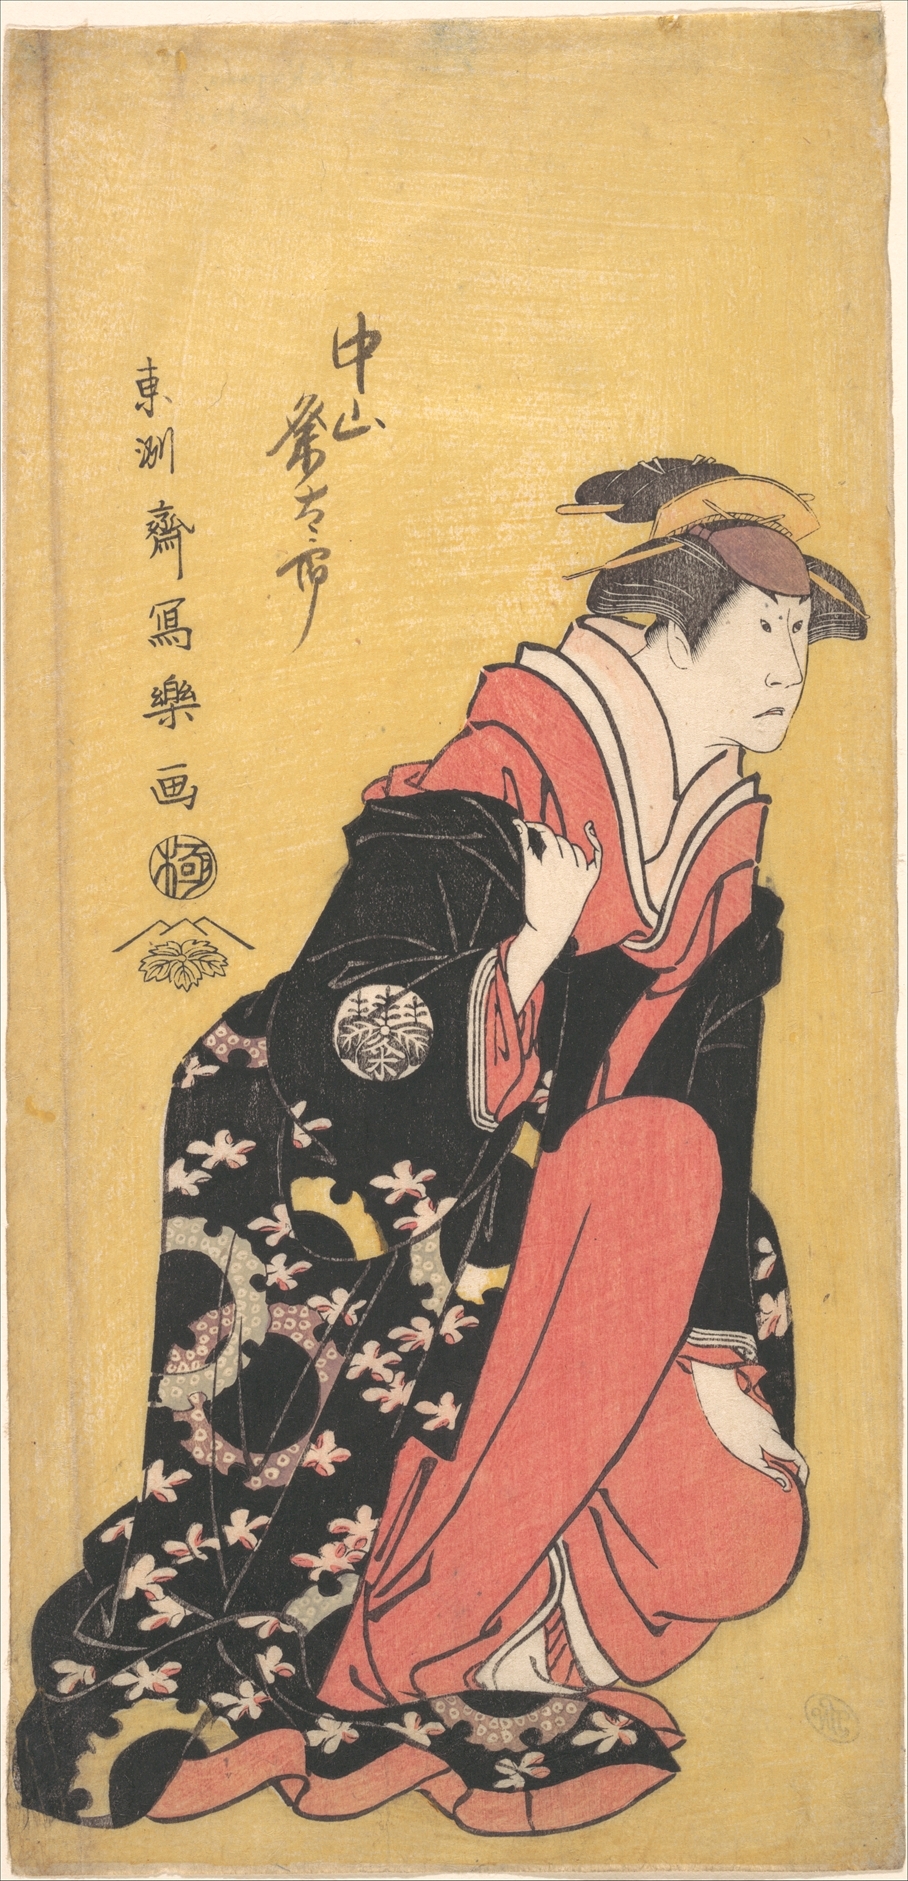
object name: print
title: The Actor Nakayama Kumetaro II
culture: japanese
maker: tōshūsai sharaku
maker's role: artist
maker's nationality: japanese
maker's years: 1794-1795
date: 1794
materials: ink, paper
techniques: woodblock print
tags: men,women,actors